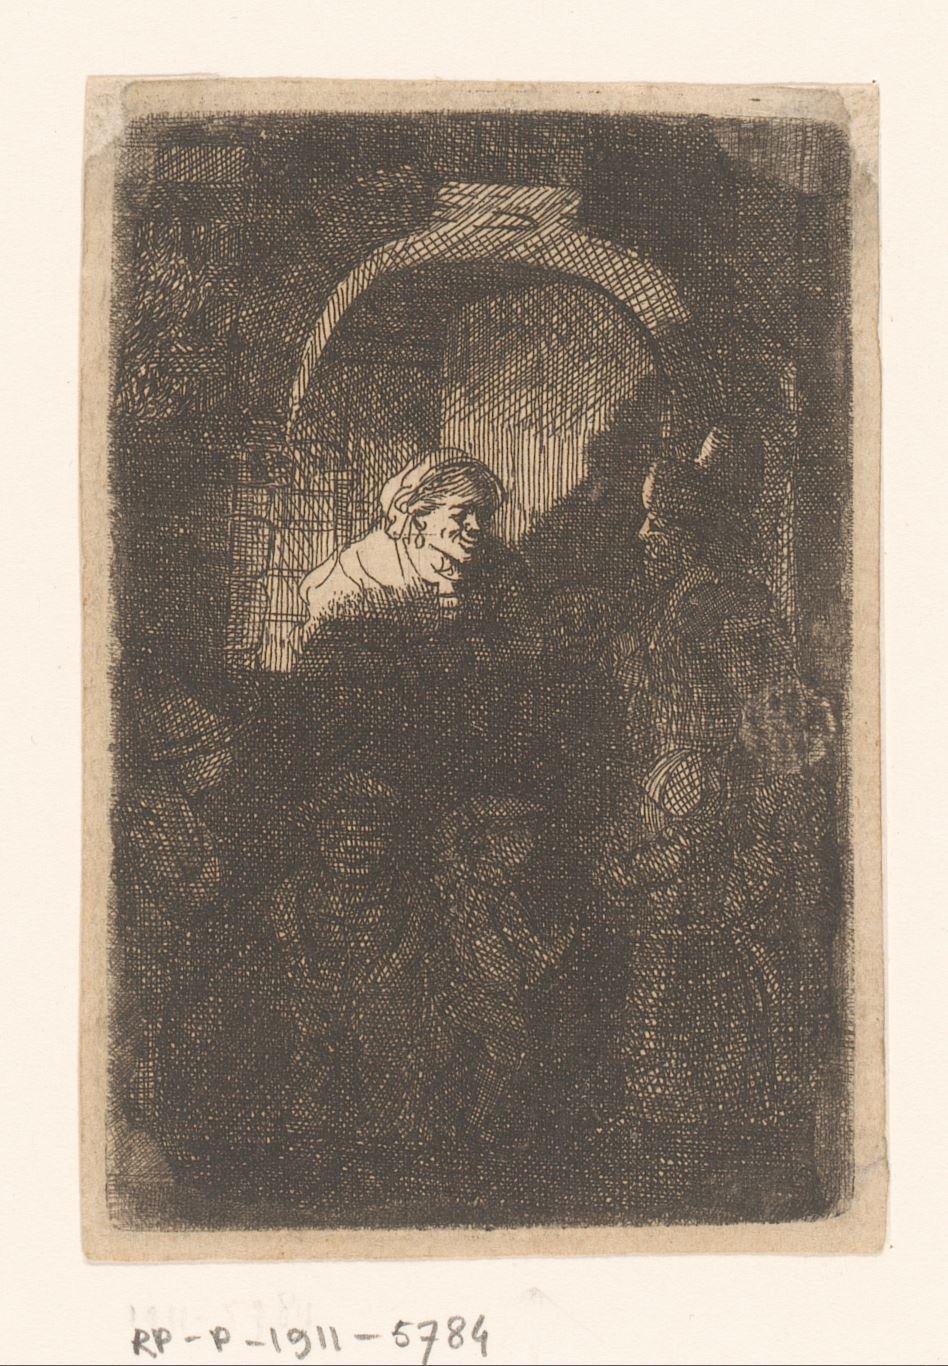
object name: print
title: Man met kinderen voor een vrouw in een venster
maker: sauveur legros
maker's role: print maker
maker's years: 1754-1834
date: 1764-1834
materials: paper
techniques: etching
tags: human figure at (open) window, seen from outside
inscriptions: collector's mark: Lugt 2228